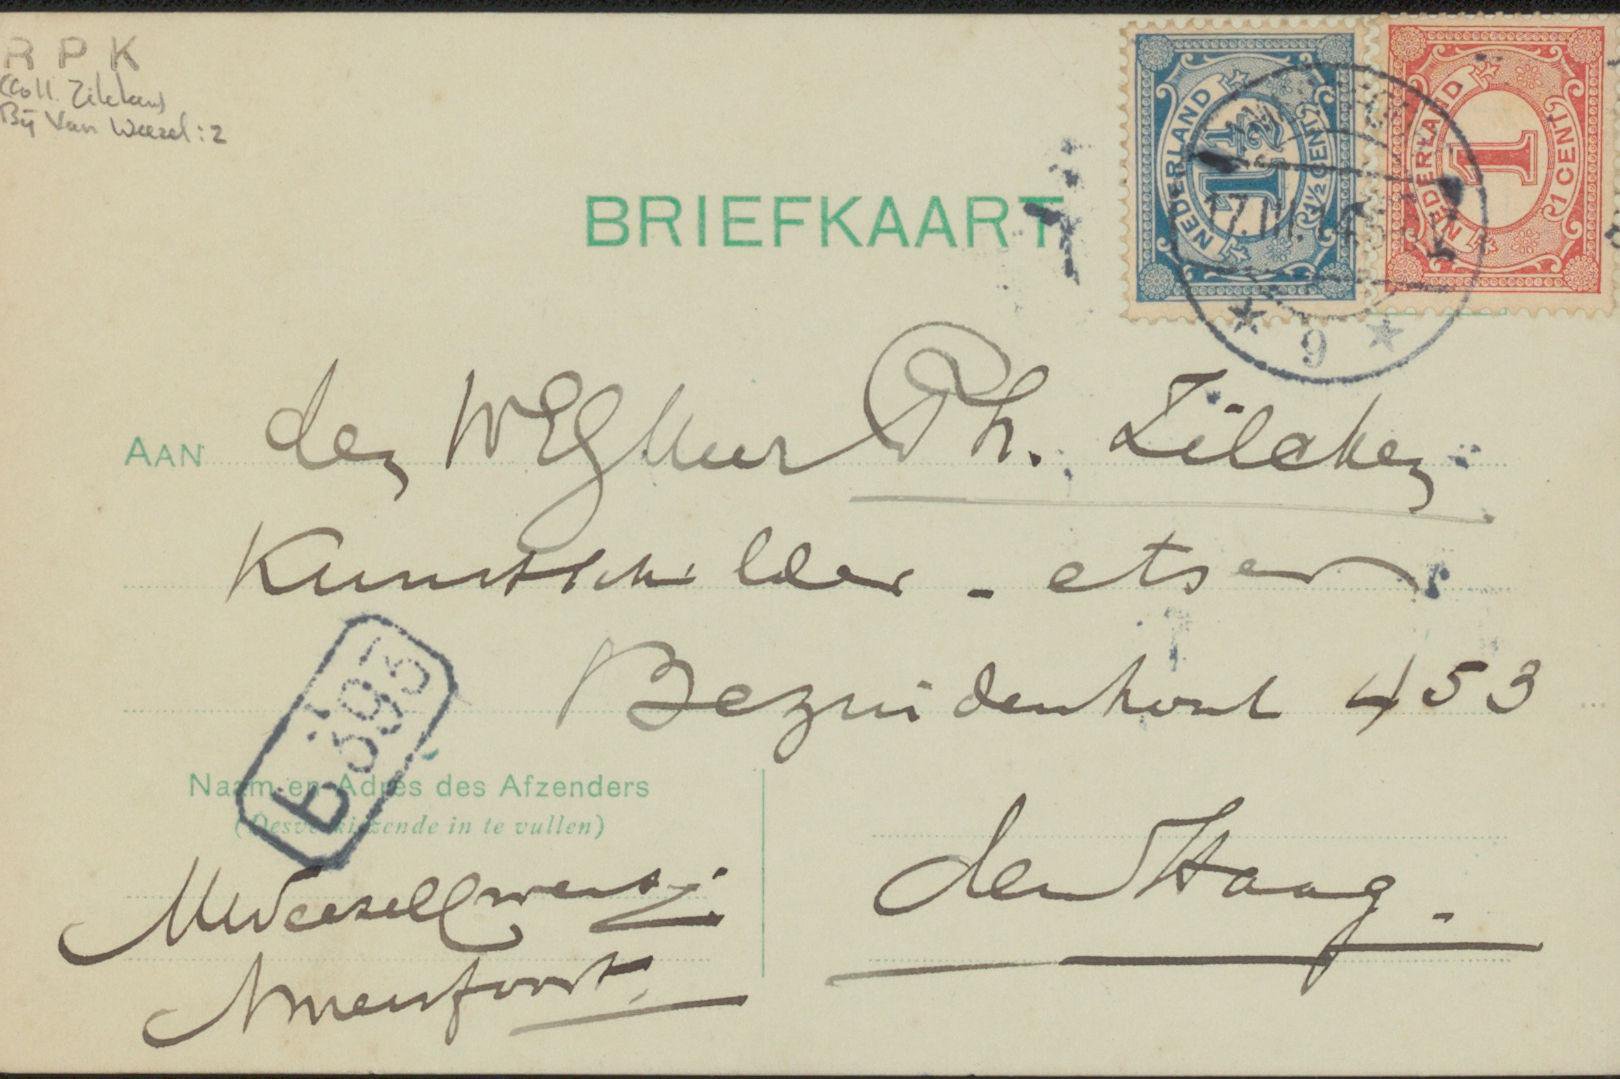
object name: postcard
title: Briefkaart aan Philip Zilcken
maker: adolphe p.h j. van weezel errens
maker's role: print maker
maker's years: 1866-1939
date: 1914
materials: cardboard, ink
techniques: pen, writing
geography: amersfoort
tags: amsterdam, painter, print maker, draughtsman, carel lodewijk dake, philip zilcken, exhibition ~ art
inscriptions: collector's mark: ‘RPK’